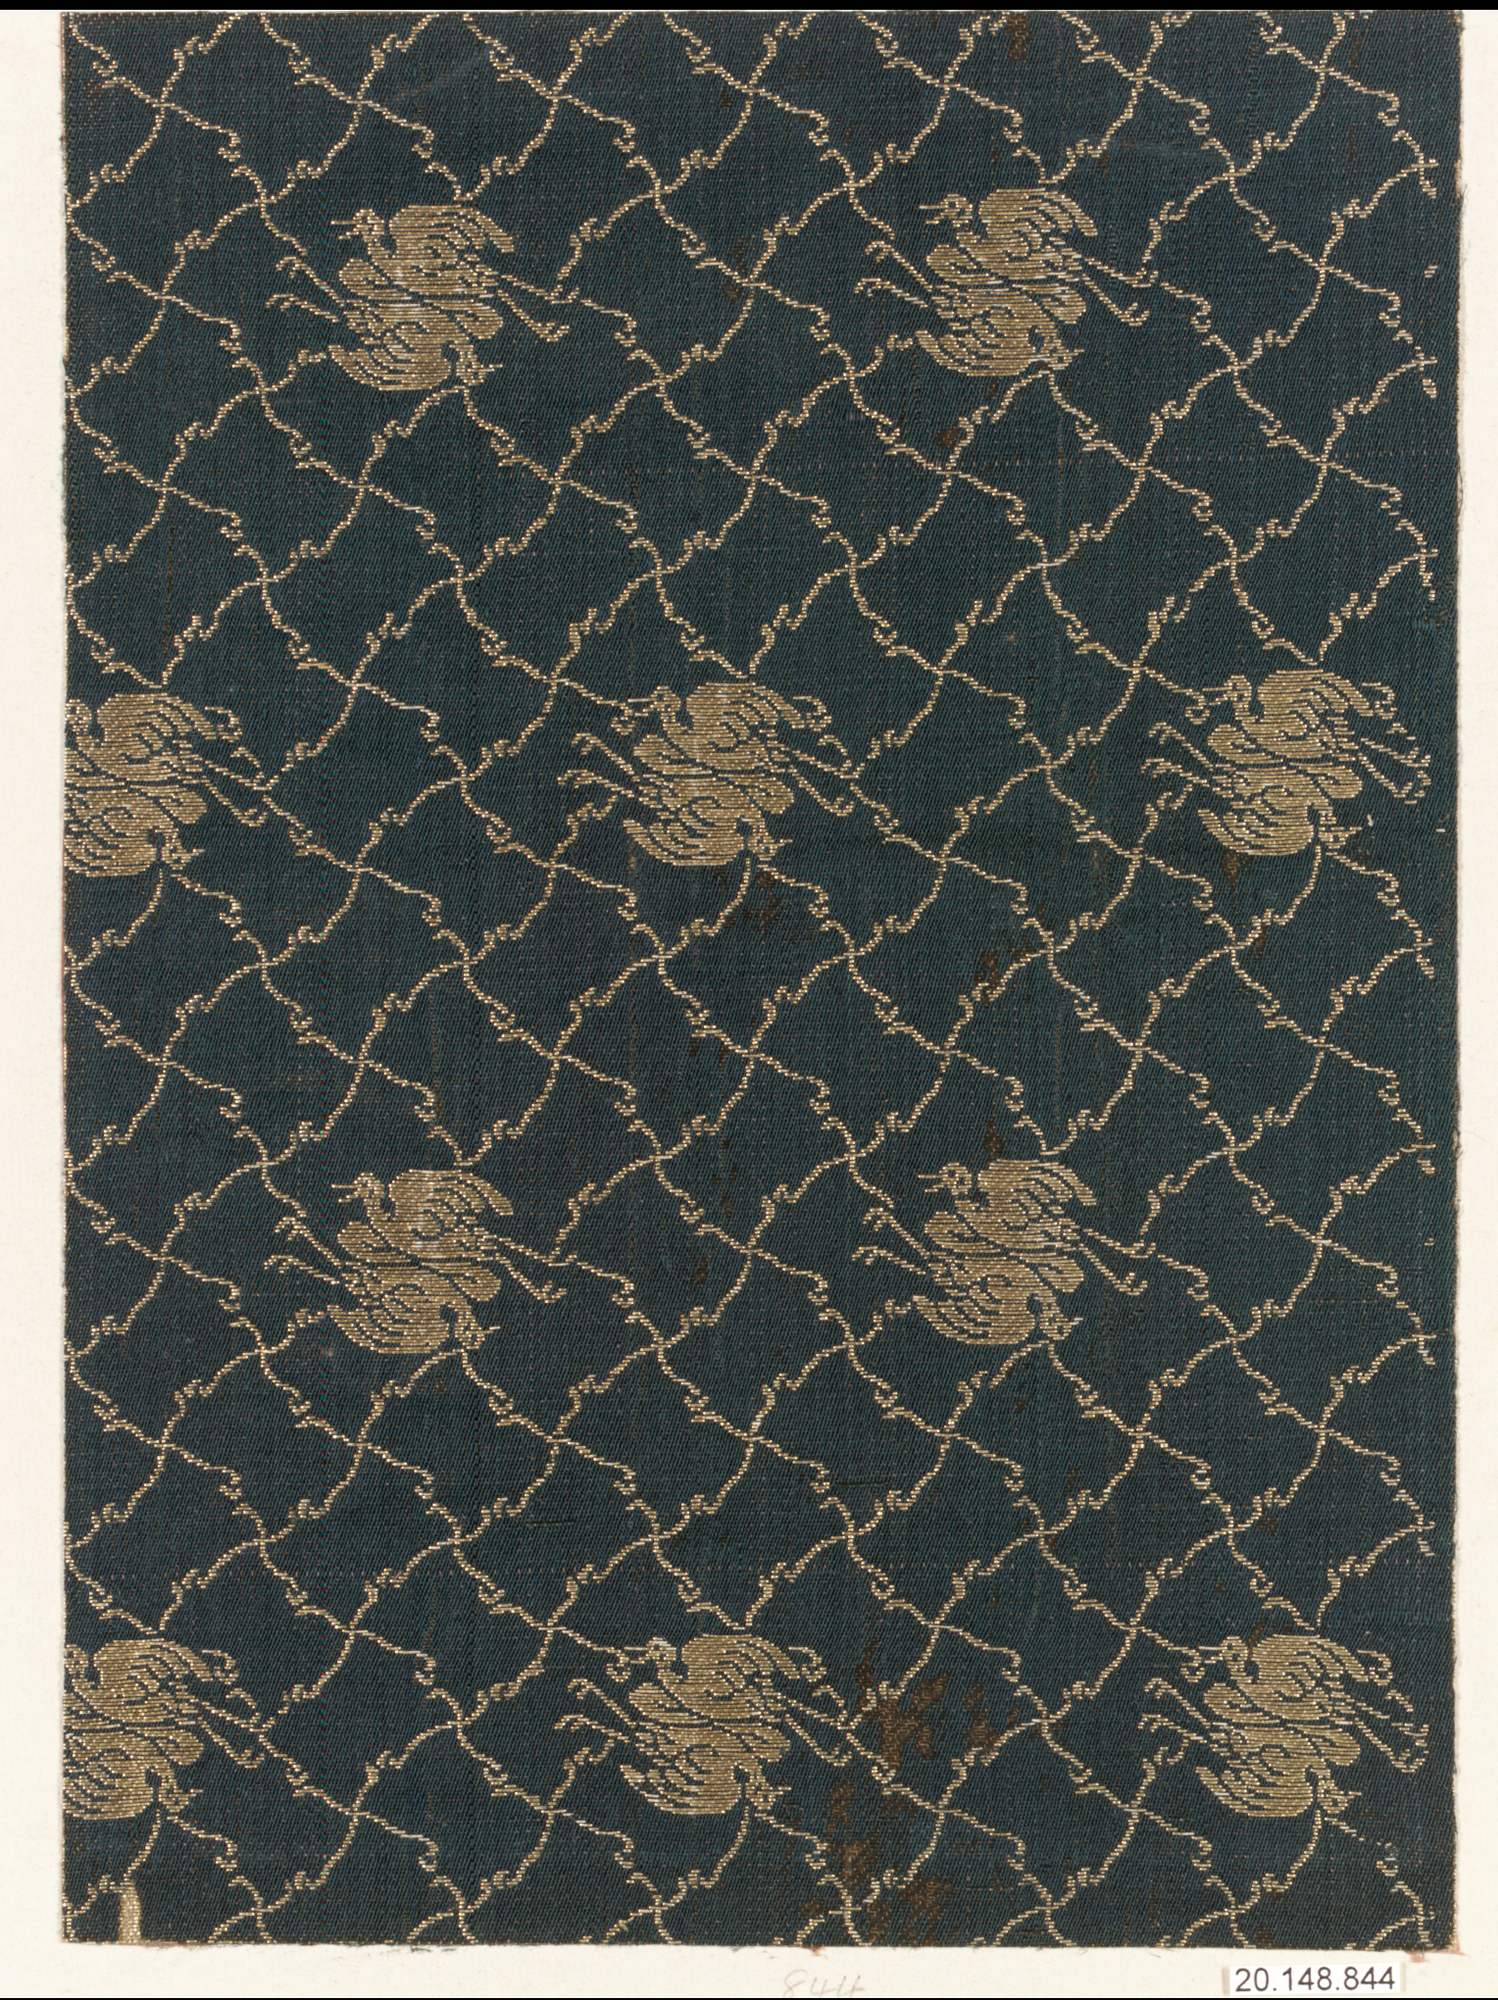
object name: piece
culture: japanese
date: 1601-1700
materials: silk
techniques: compound weave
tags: birds